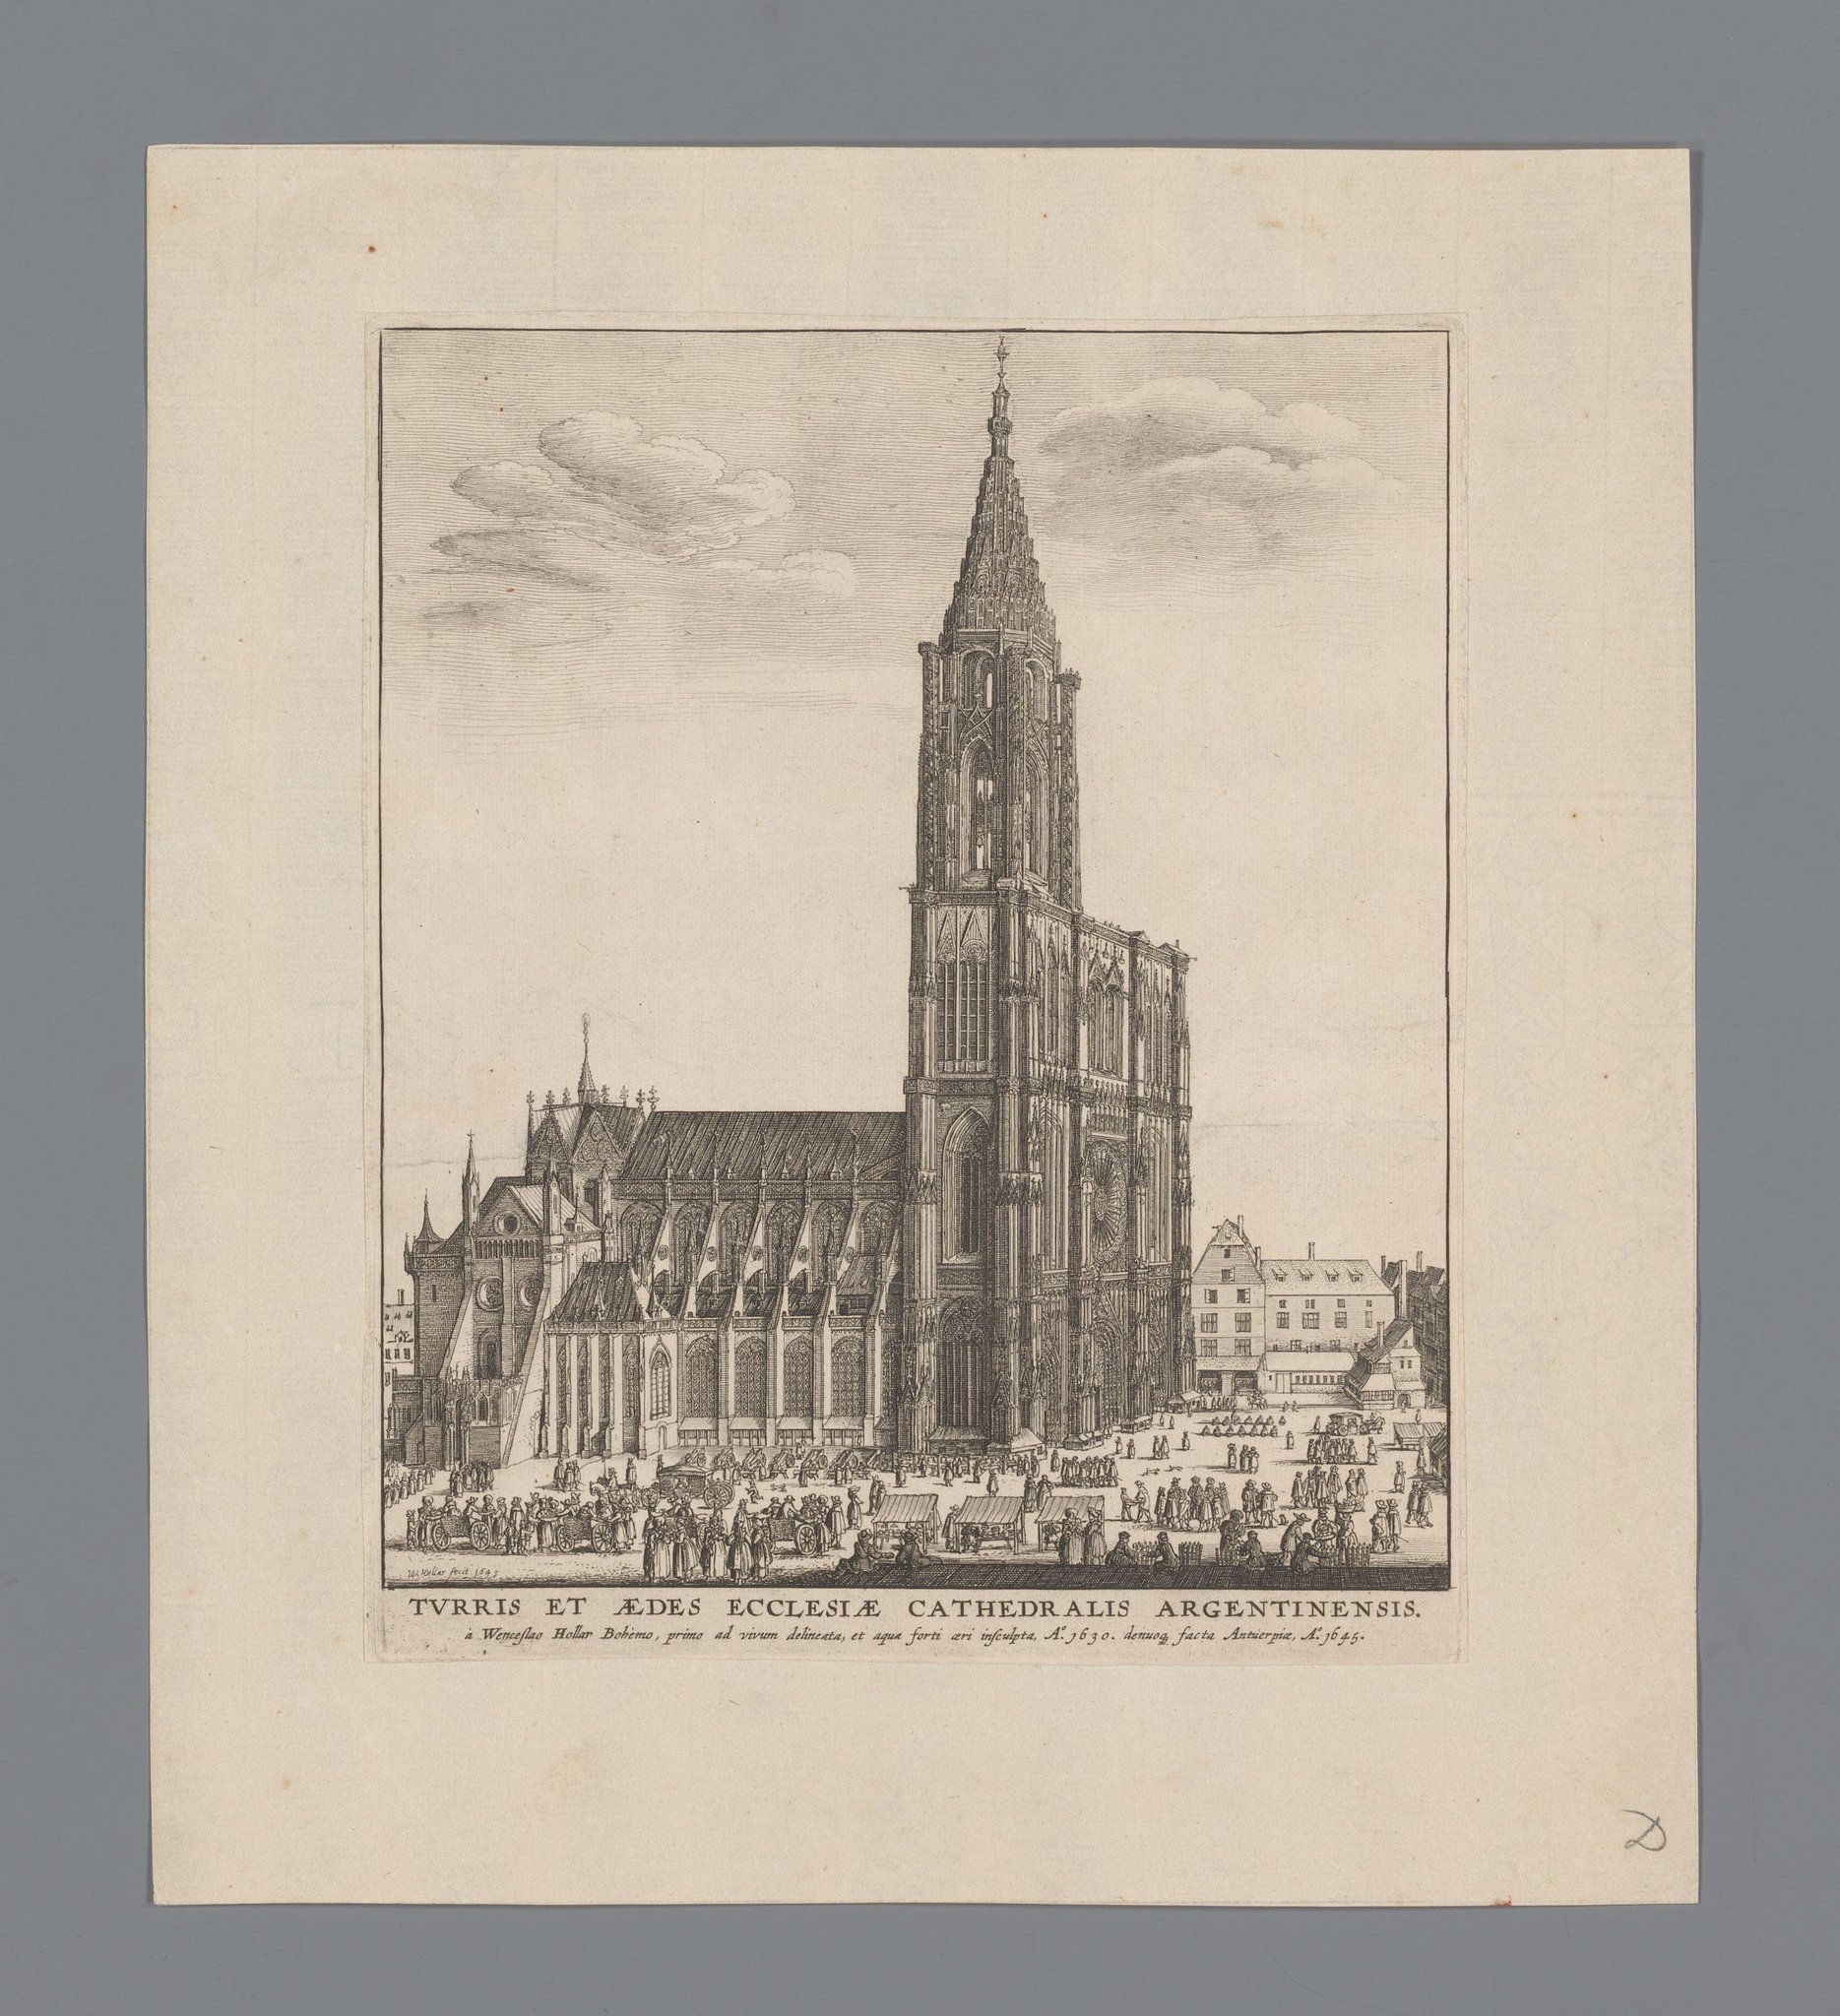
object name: print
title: Turris et Aedes Ecclesiae Cathedralis Argentinensis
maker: wenceslaus hollar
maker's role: draughtsman, print maker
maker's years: 1607-1677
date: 1645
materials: paper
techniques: etching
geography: antwerp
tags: church (exterior)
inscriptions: collector's mark: Lugt 2228